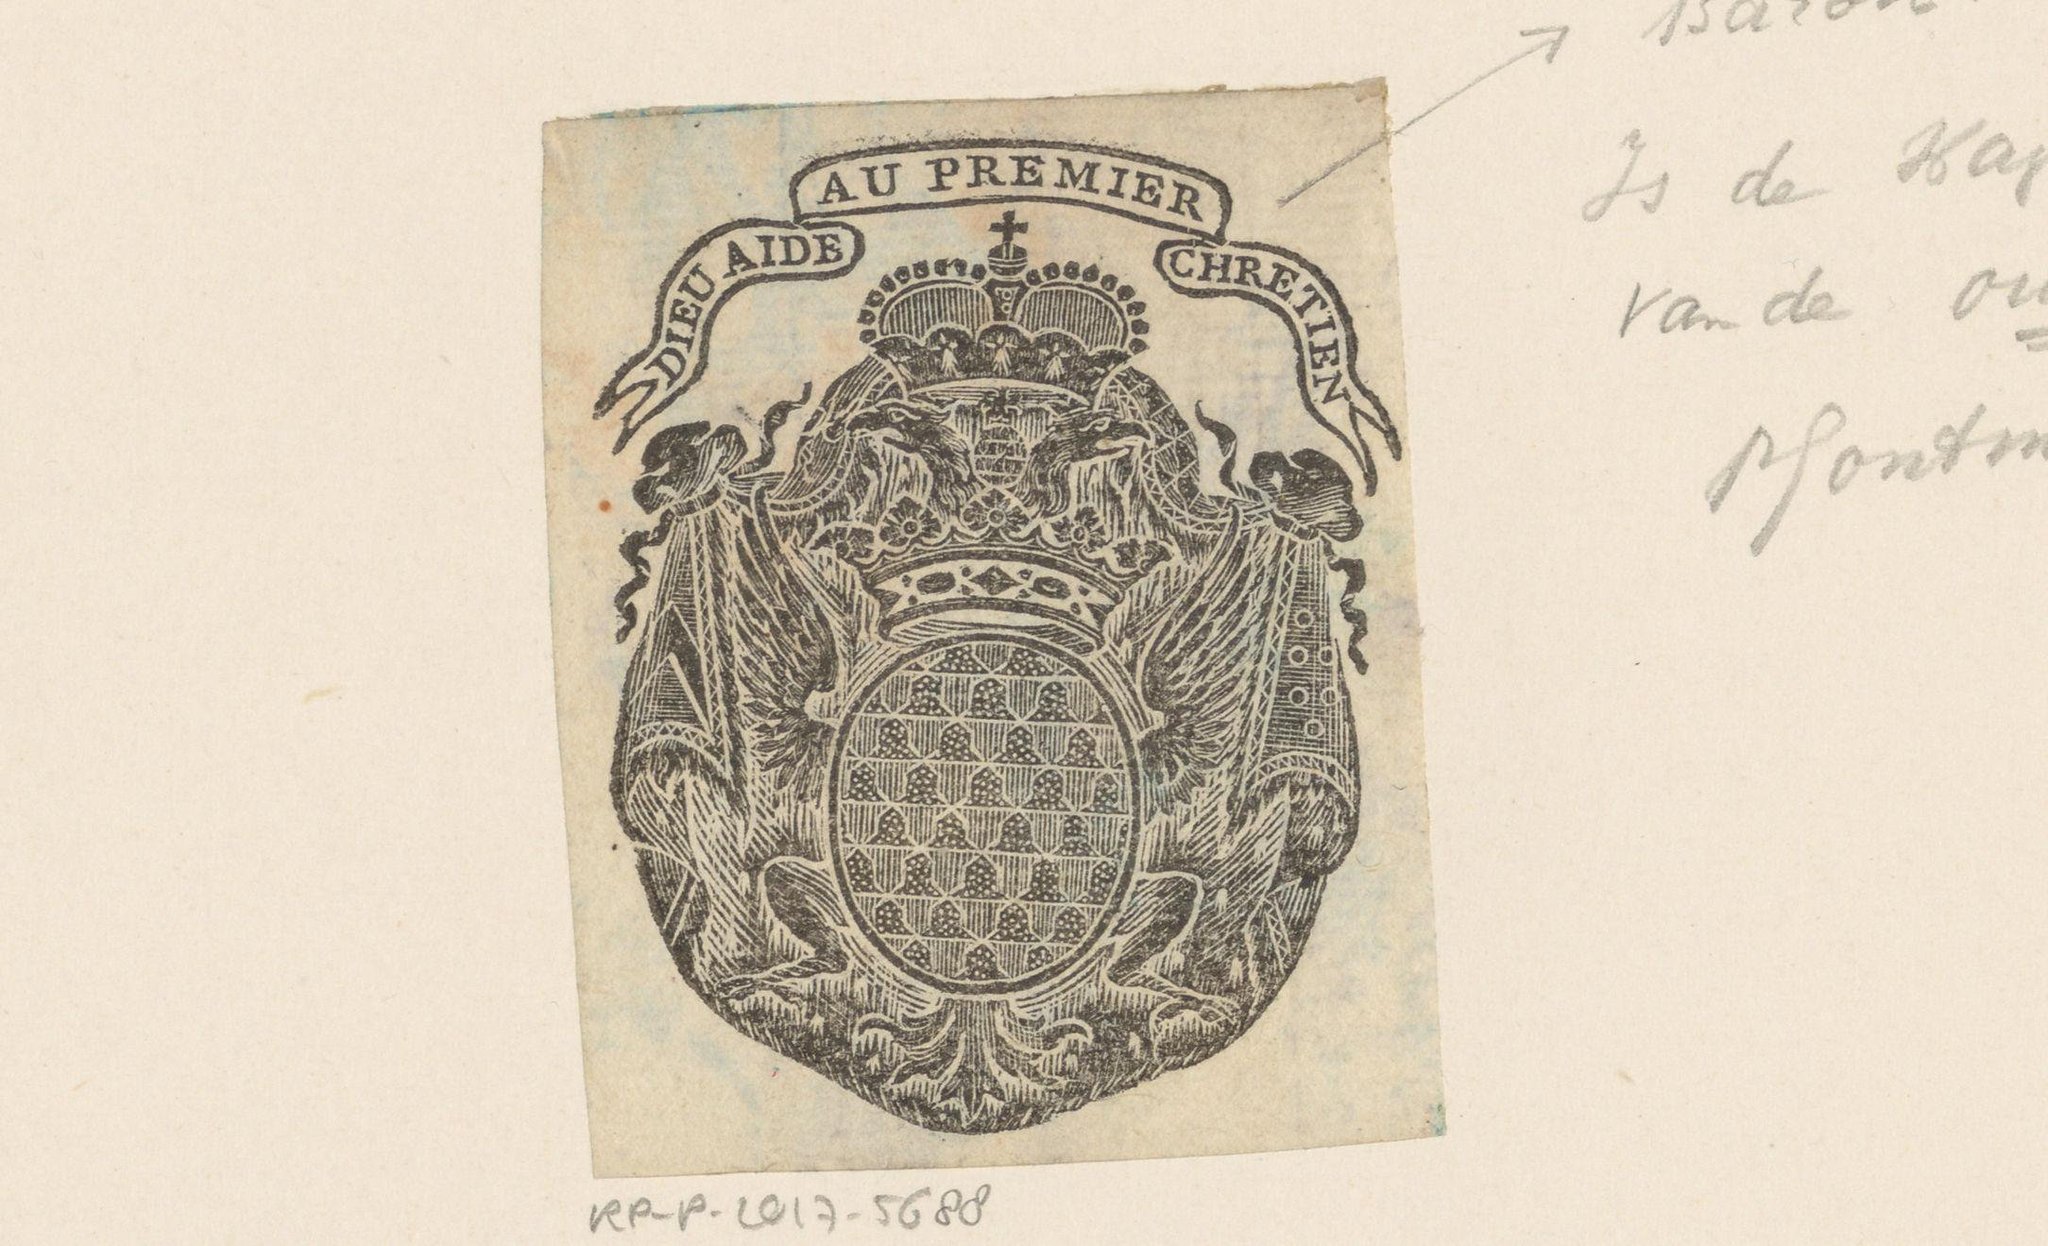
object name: bookplate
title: Ex libris van Montmorency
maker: Anonymous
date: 1700-1799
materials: paper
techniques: woodcut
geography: france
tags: armorial bearing, heraldry